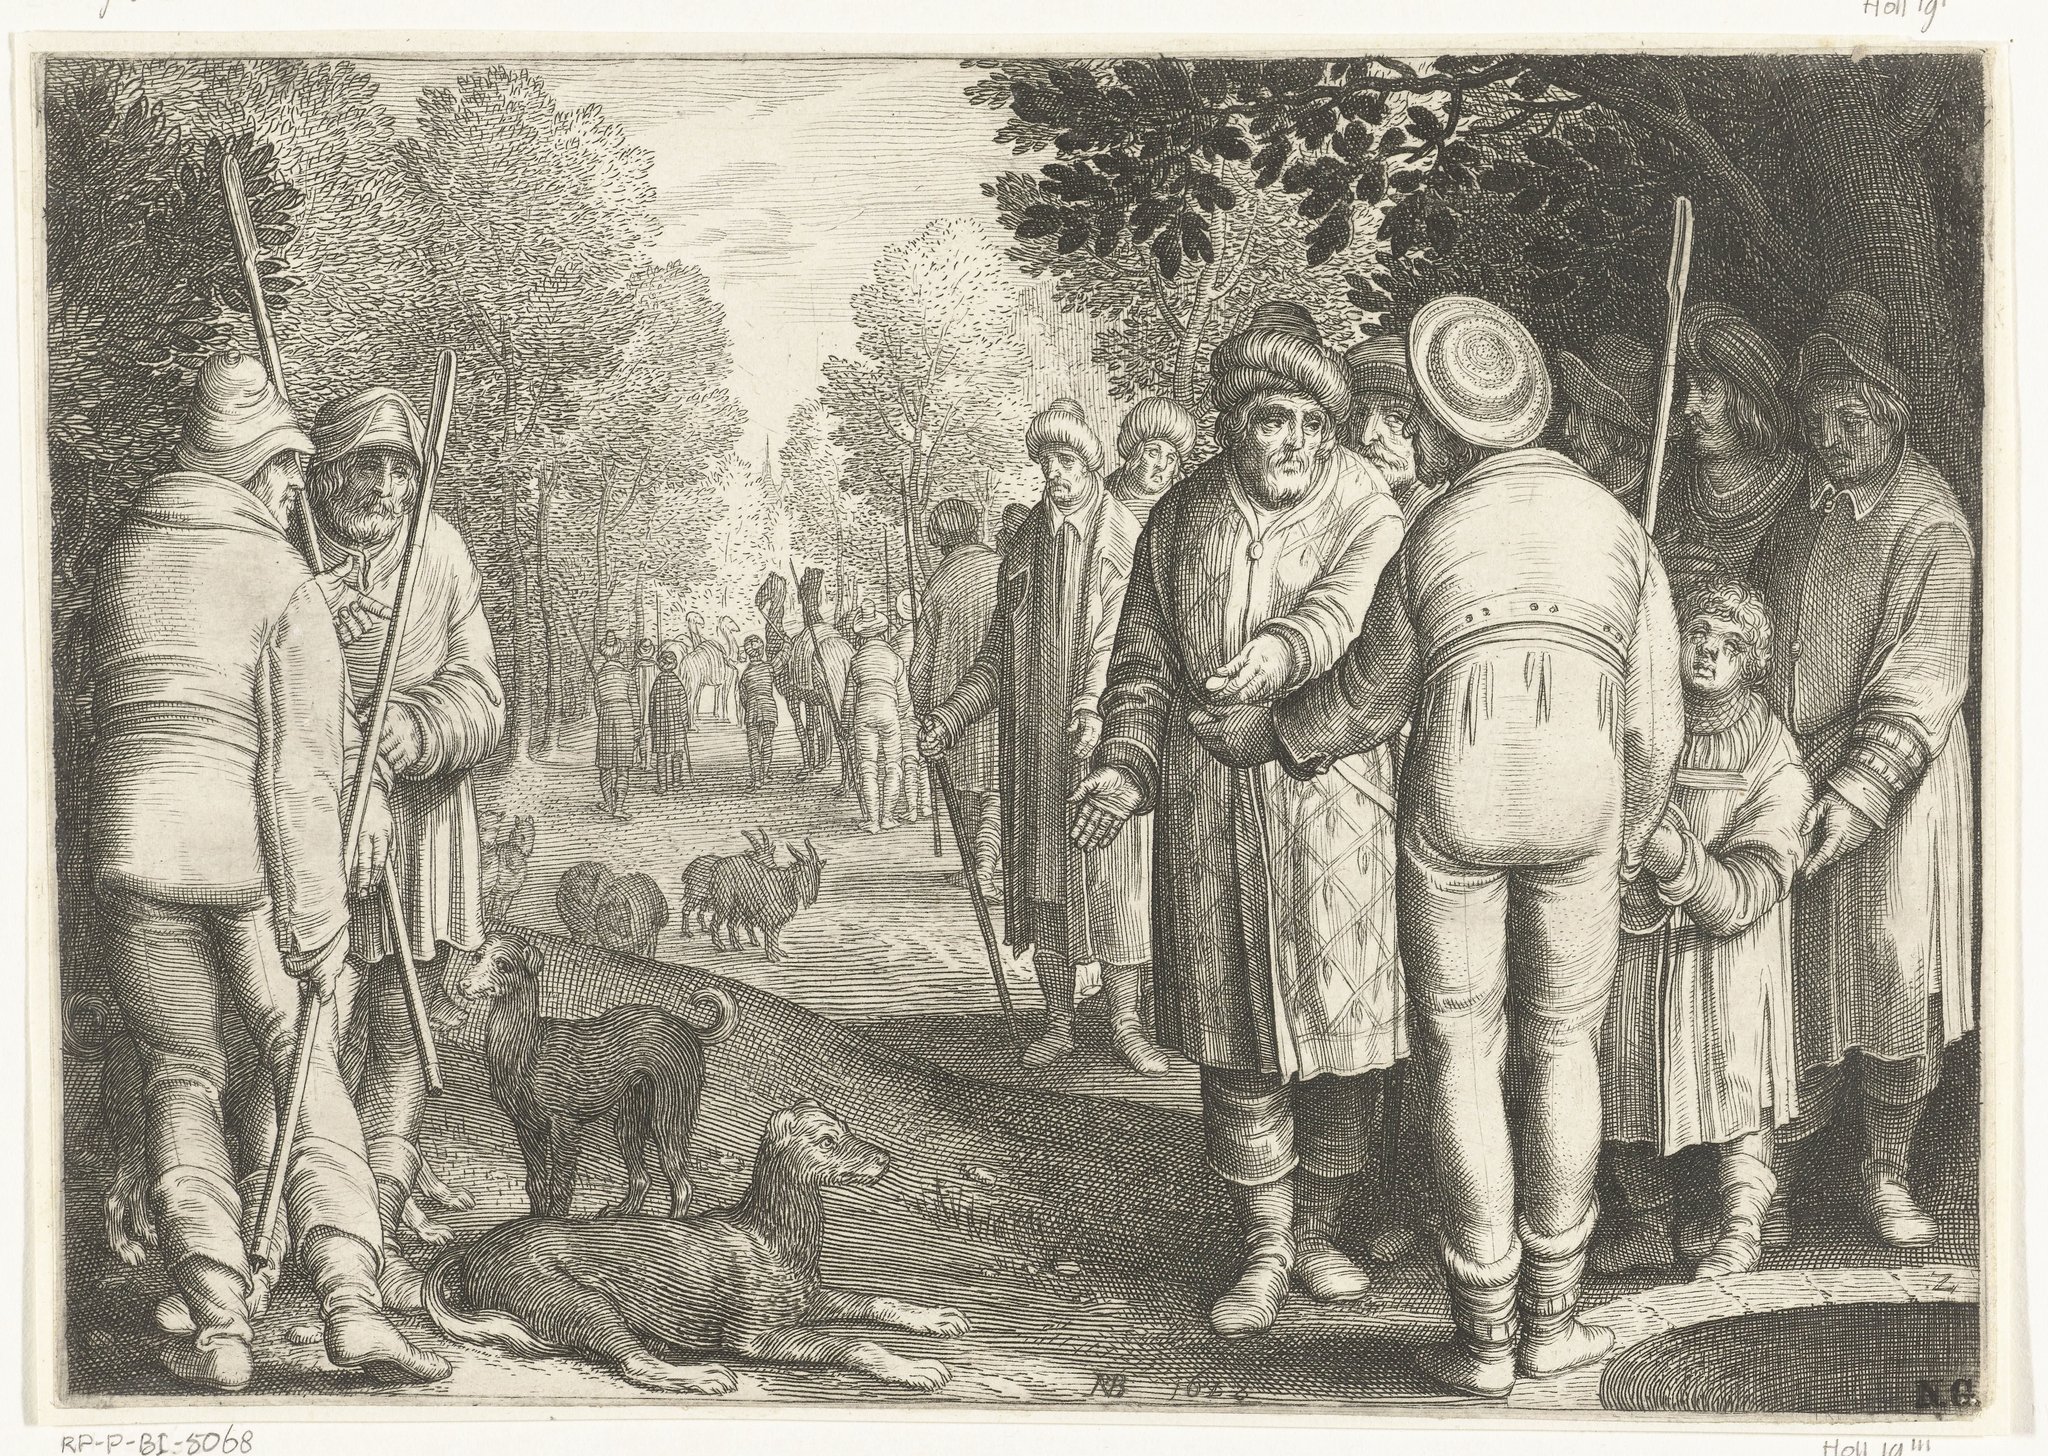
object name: print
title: Jozef wordt door zijn broers verkocht aan kooplieden bij de put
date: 1628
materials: paper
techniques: engraving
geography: netherlands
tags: joseph is sold for twenty pieces of silver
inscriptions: collector's mark: Lugt 1967, collector's mark: Lugt 2228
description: Prent uit serie van zes prenten met het verhaal van Jozef. De serie is geïnspireerd op een vergelijkbare reeks van Lucas van Leyden.